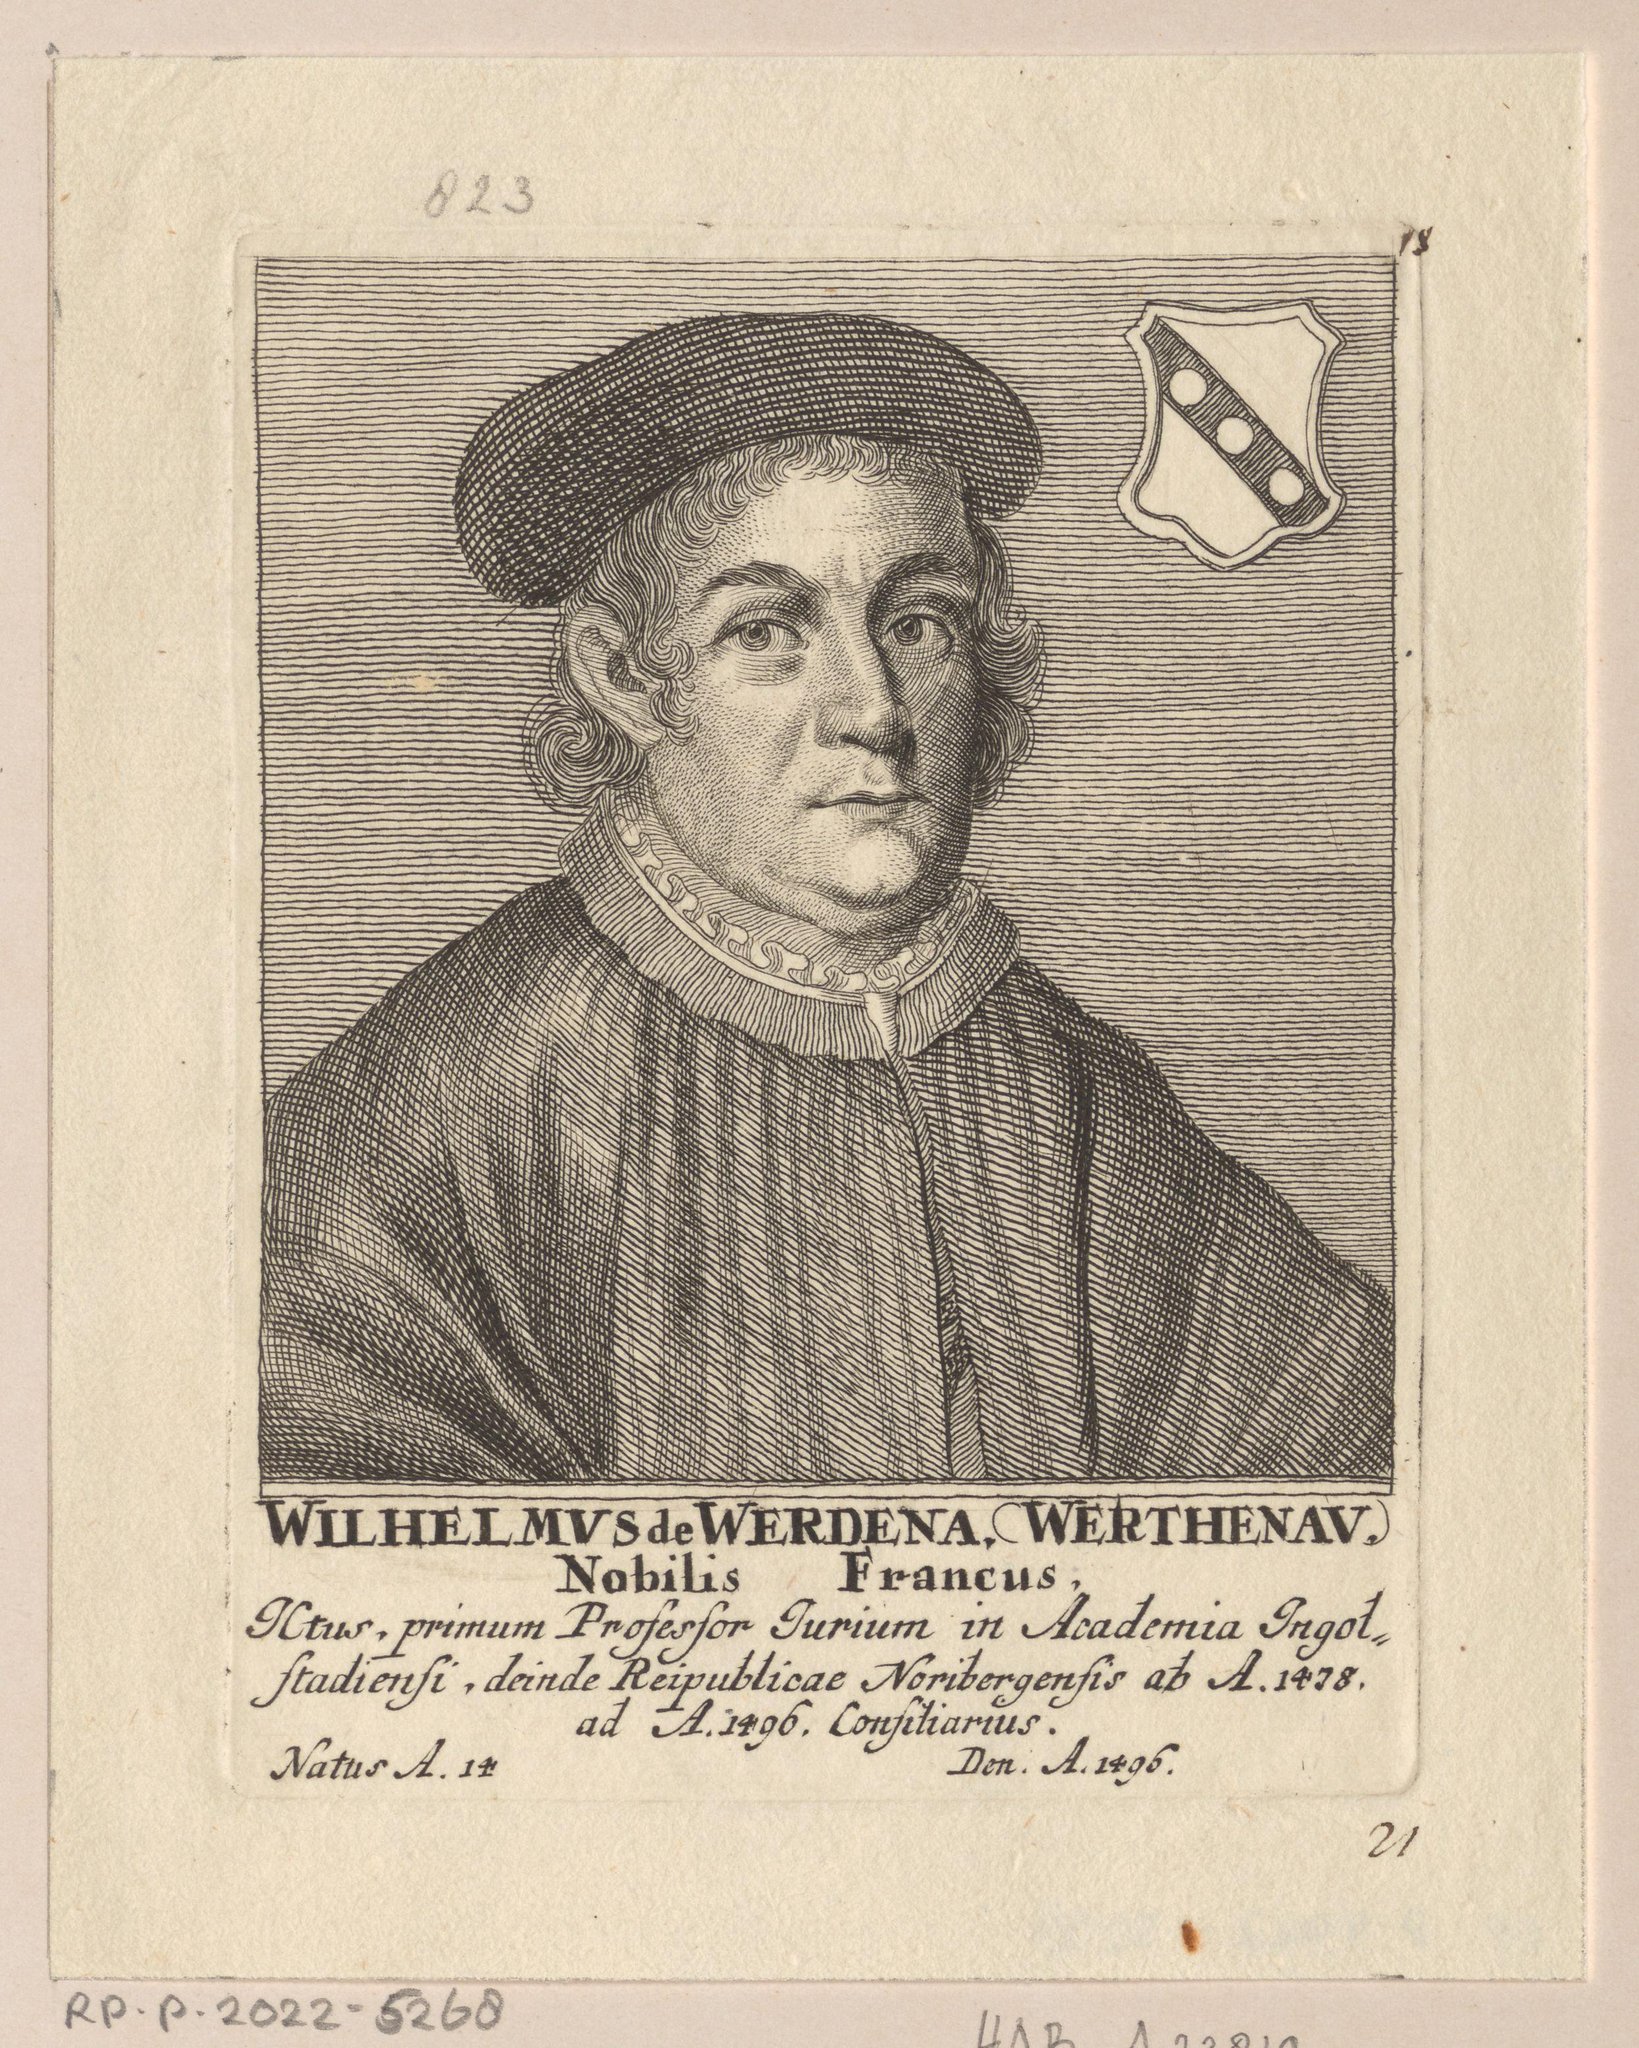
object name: print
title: Portret van Wilhelm von Werthenau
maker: Anonymous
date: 1725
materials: paper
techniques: engraving, etching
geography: germany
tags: historical persons, armorial bearing, heraldry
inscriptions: number: ‘18’, number: ‘21’, number: ‘823’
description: Prent mogelijk uit: Rothscholtz, Friedrich. Icones virorum omnium ordinum eruditione: omnique item genere et varietate artium de republica litteraria et speciatim de Academiis et Gymnasiis (...). Neurenberg: erven Johann Daniel Tauber, 1725